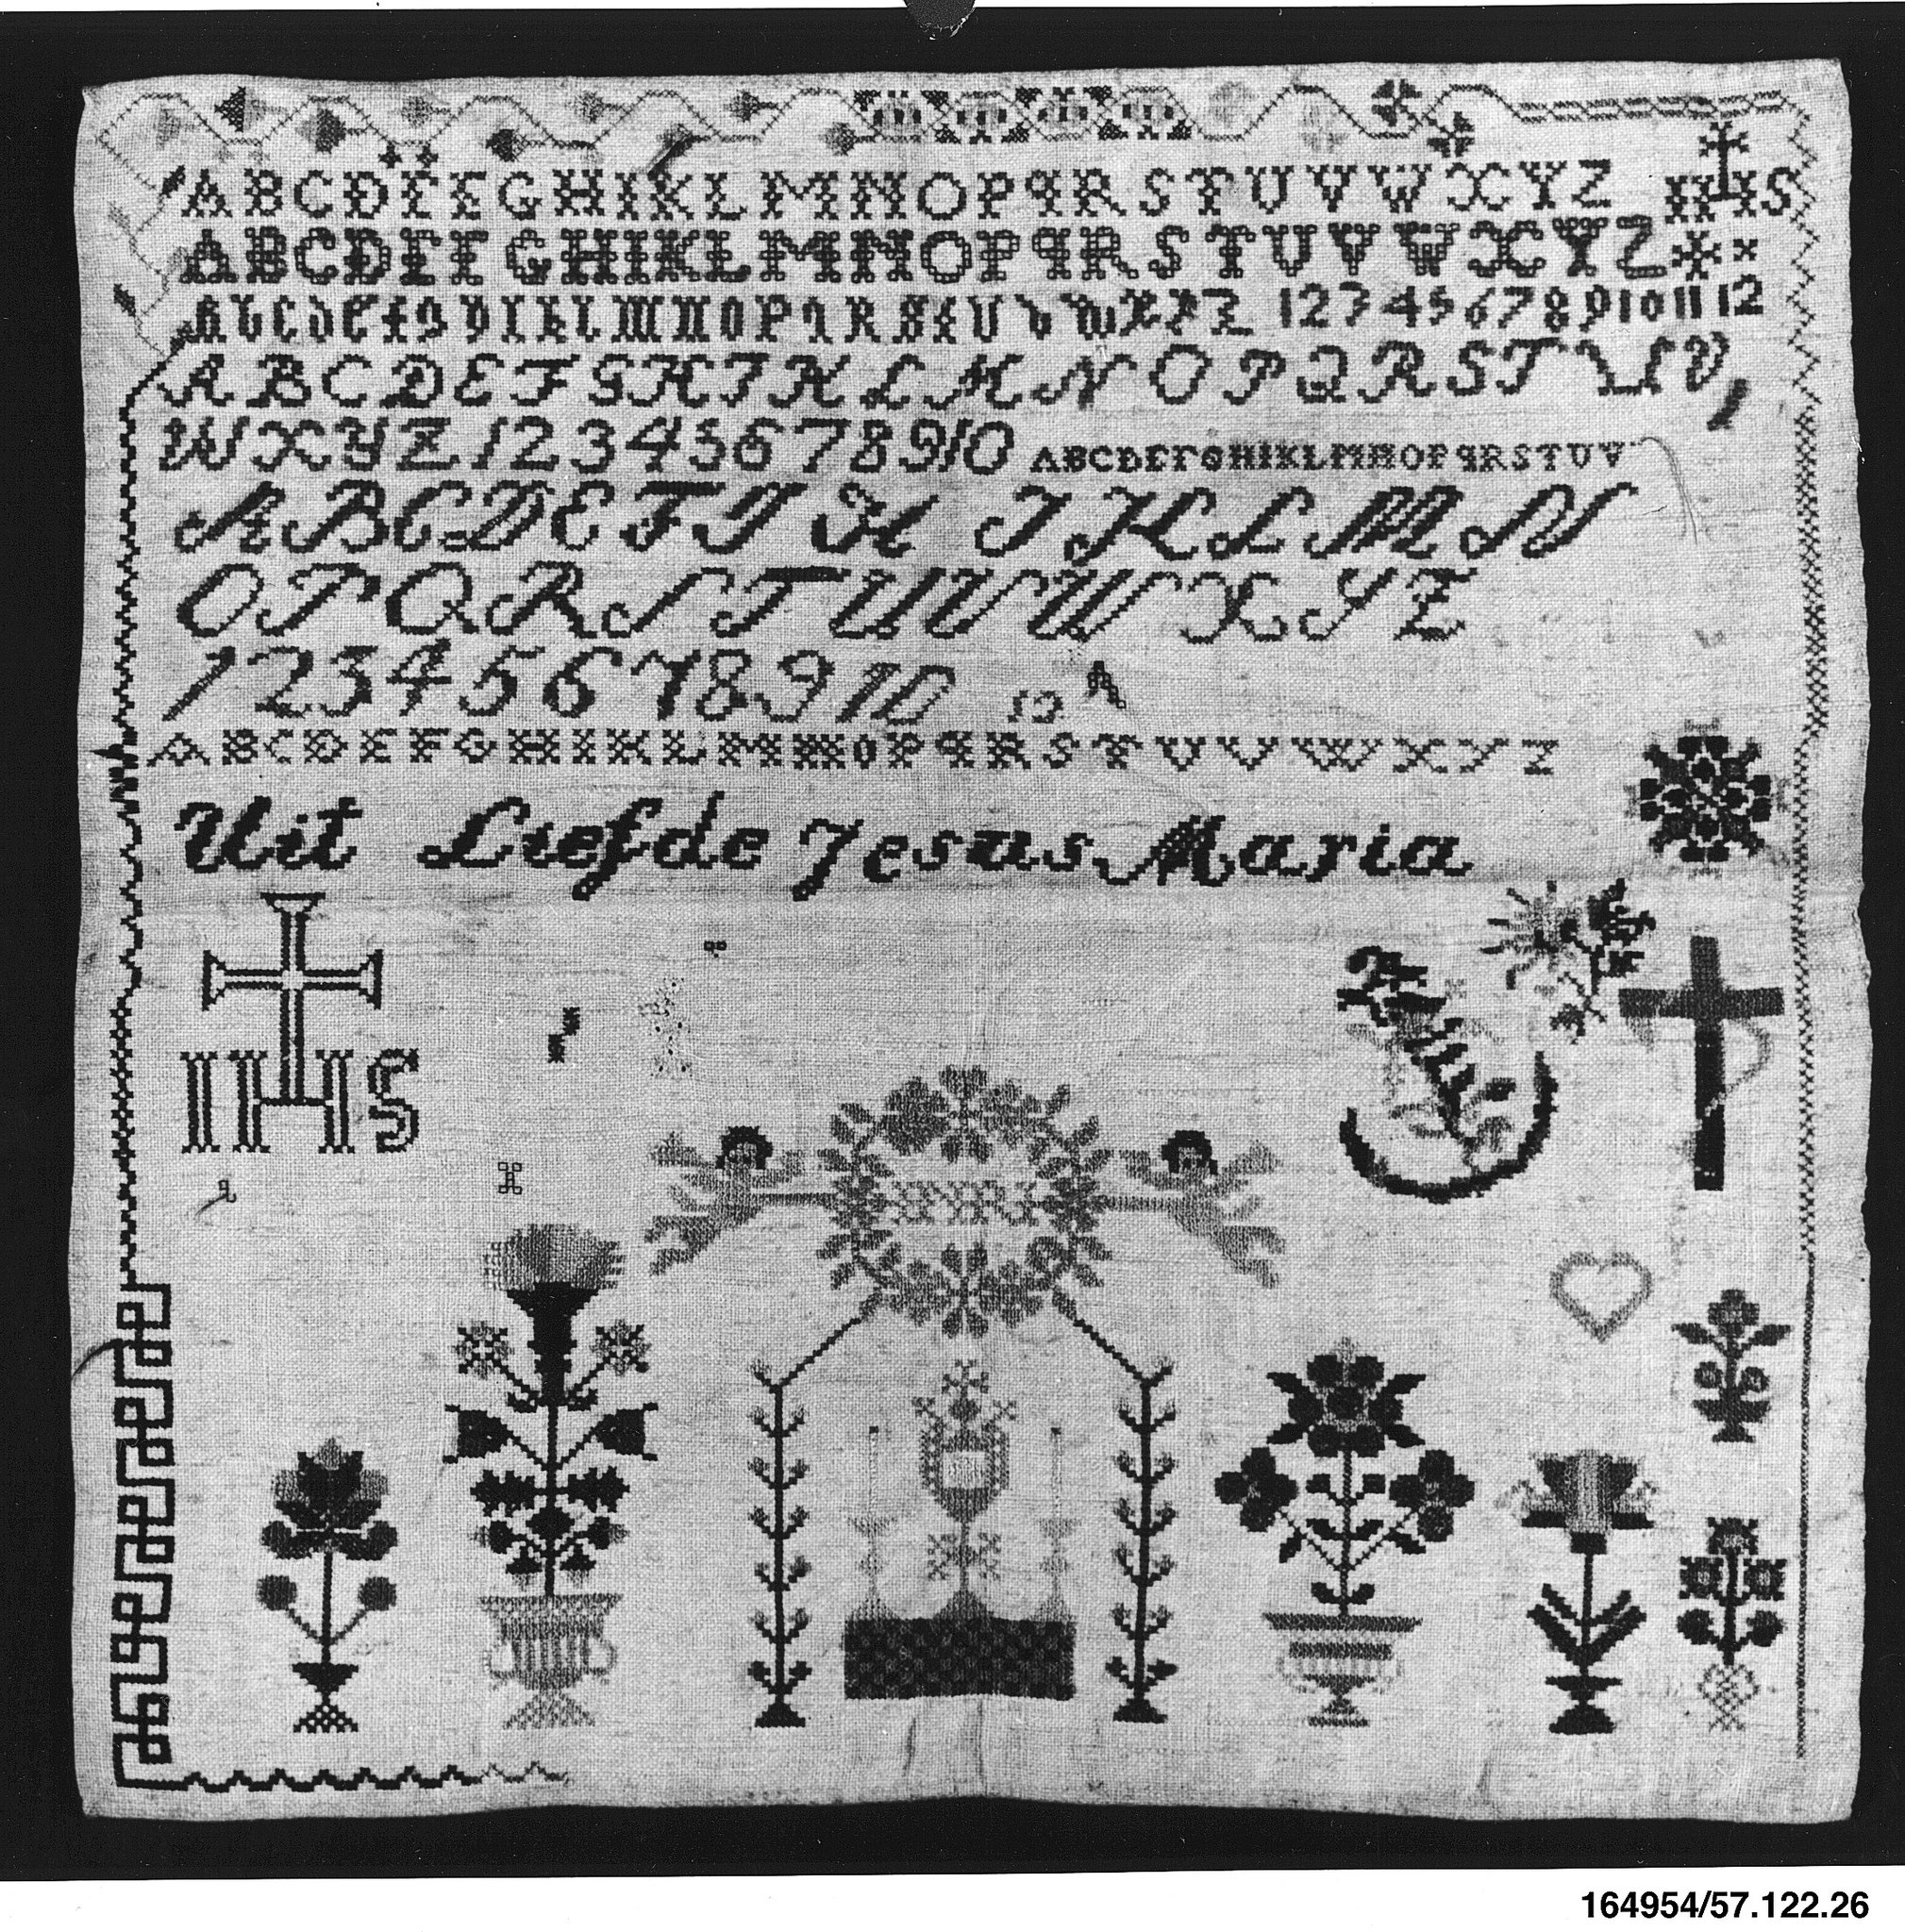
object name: sampler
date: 1801-1900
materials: linen, silk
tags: flowers,cross